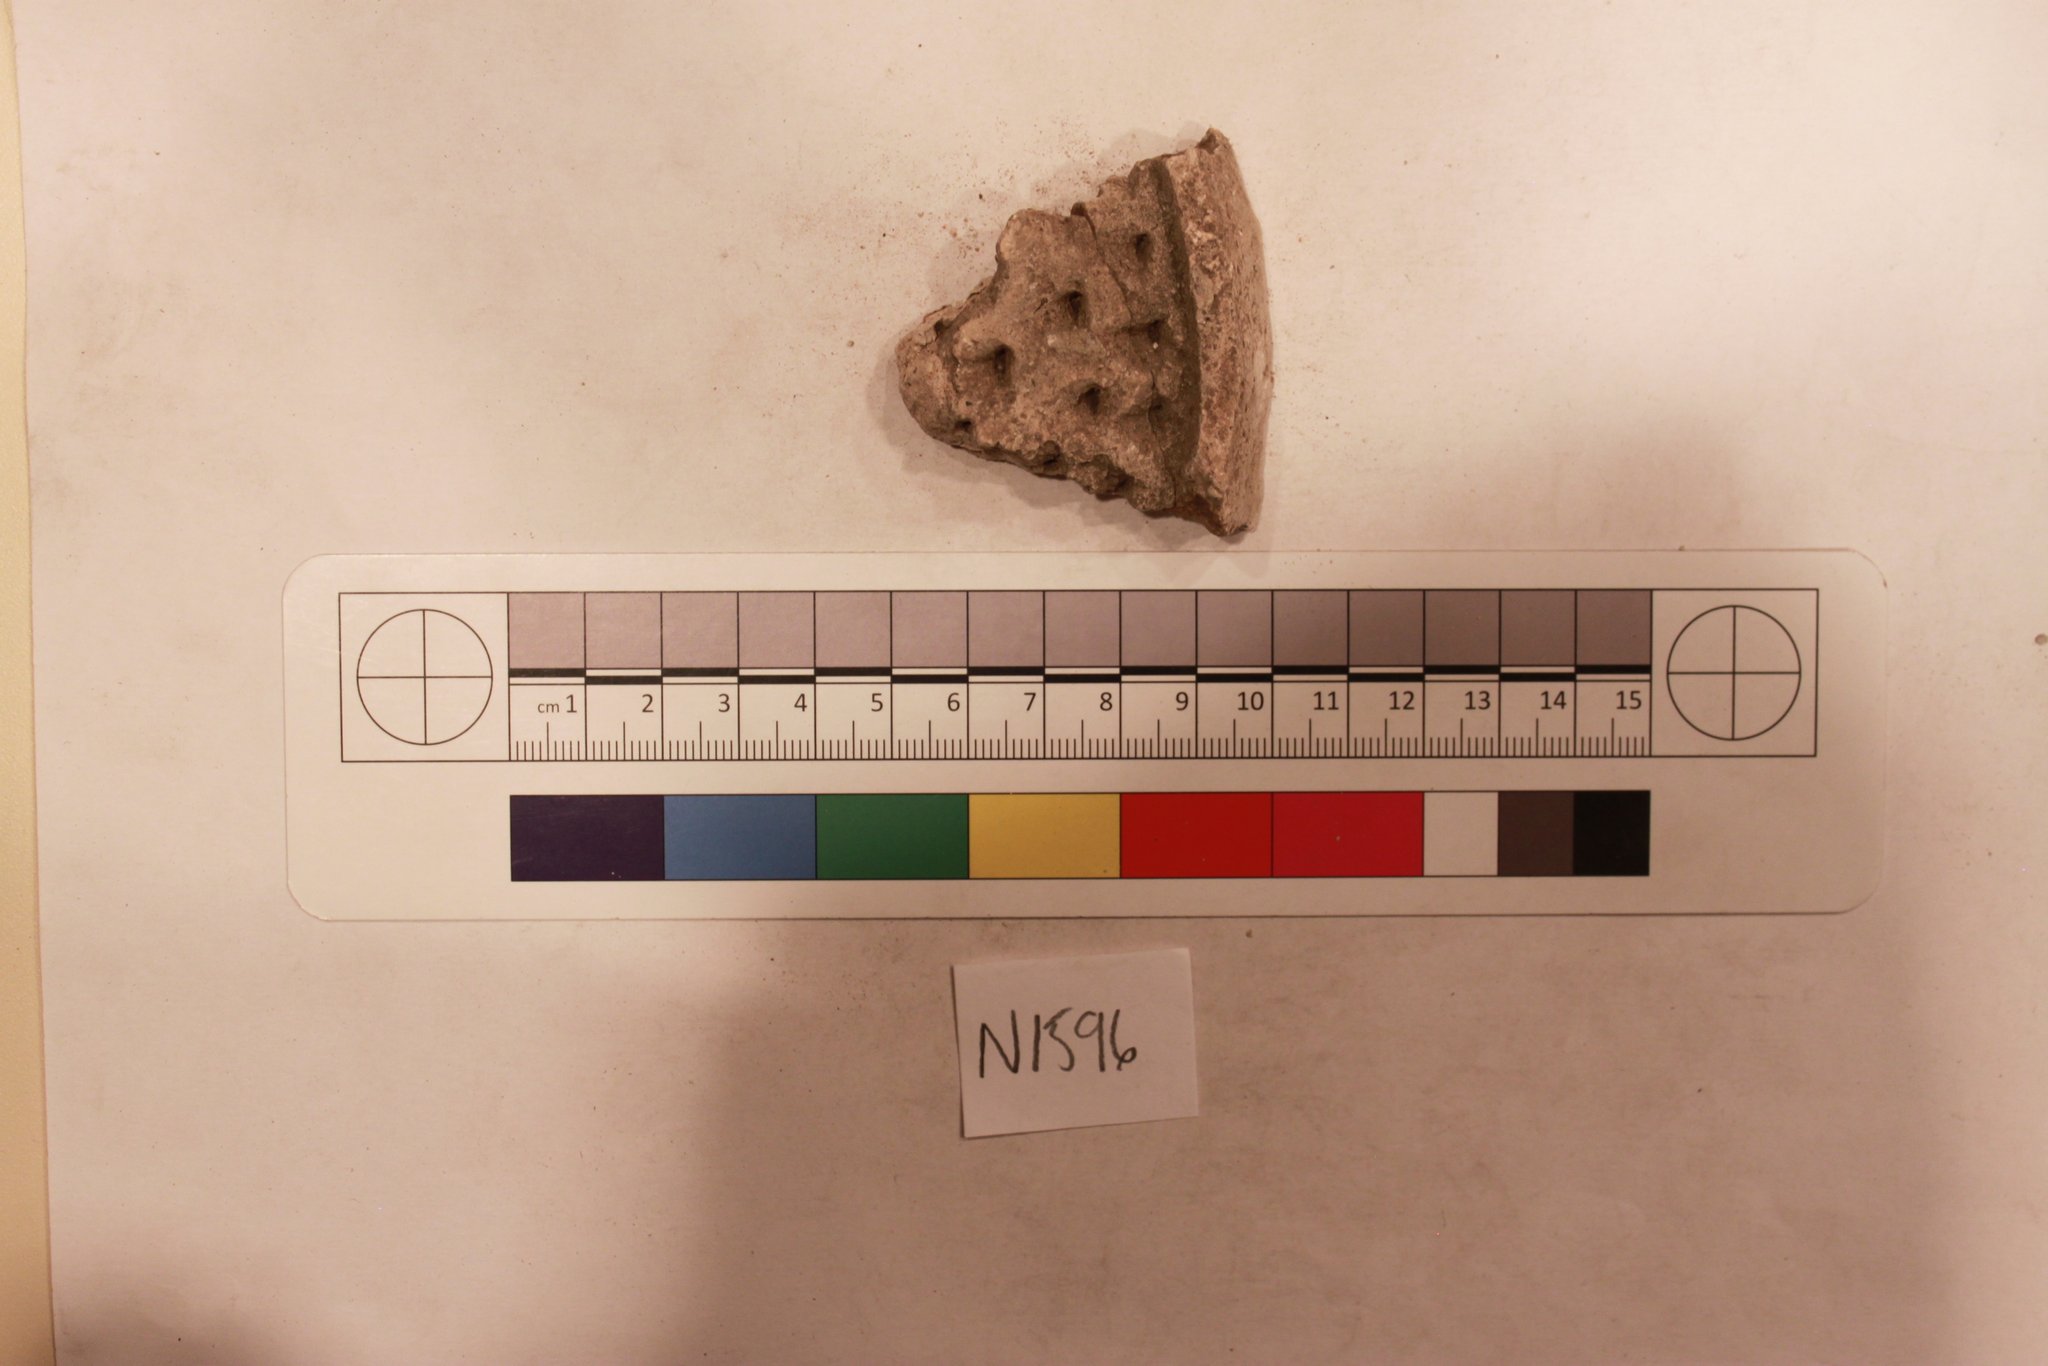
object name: fragment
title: Stucco Fragment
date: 701-1200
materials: plaster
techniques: carving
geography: iran